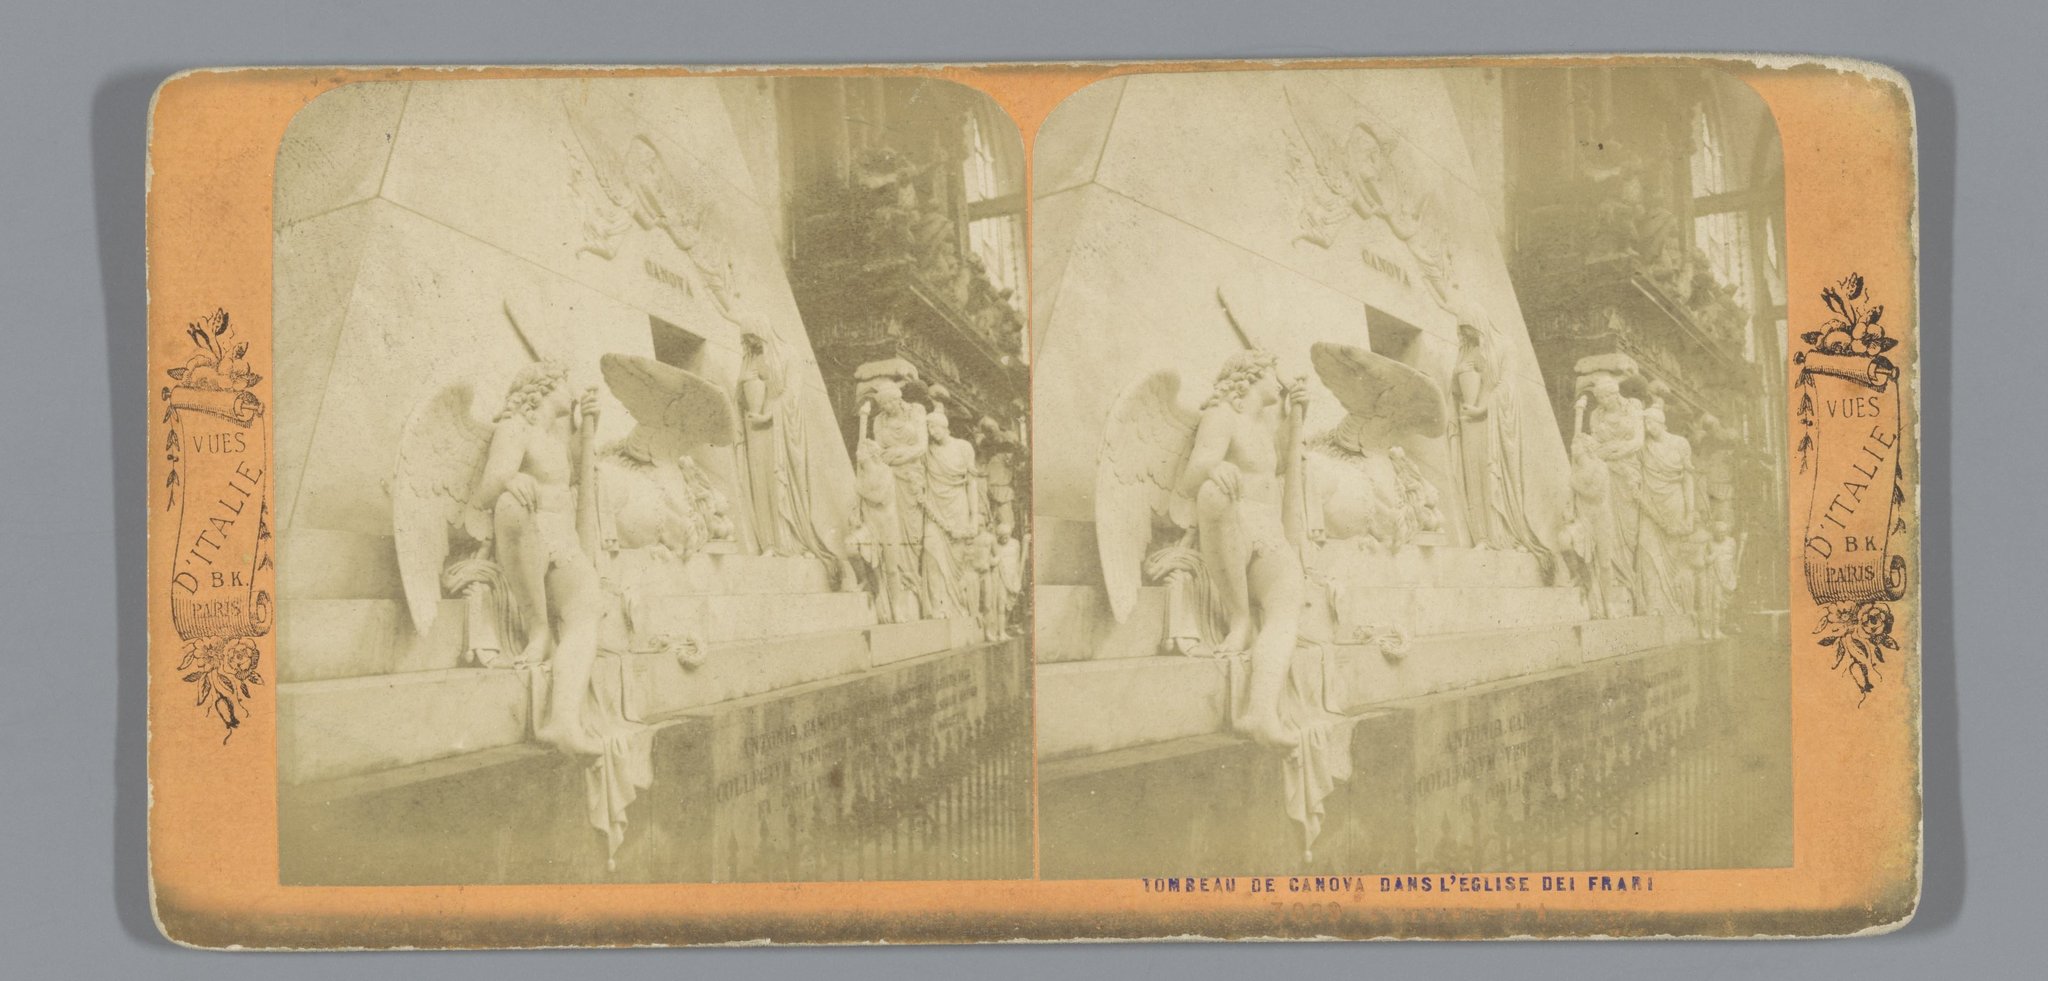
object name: stereograph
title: Tombeau de Canova dans l'église dei Frari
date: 1872-1876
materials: cardboard, paper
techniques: albumen print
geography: paris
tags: grave, tomb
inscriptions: number: ‘3029’, title: ‘No 3029/ venetie’